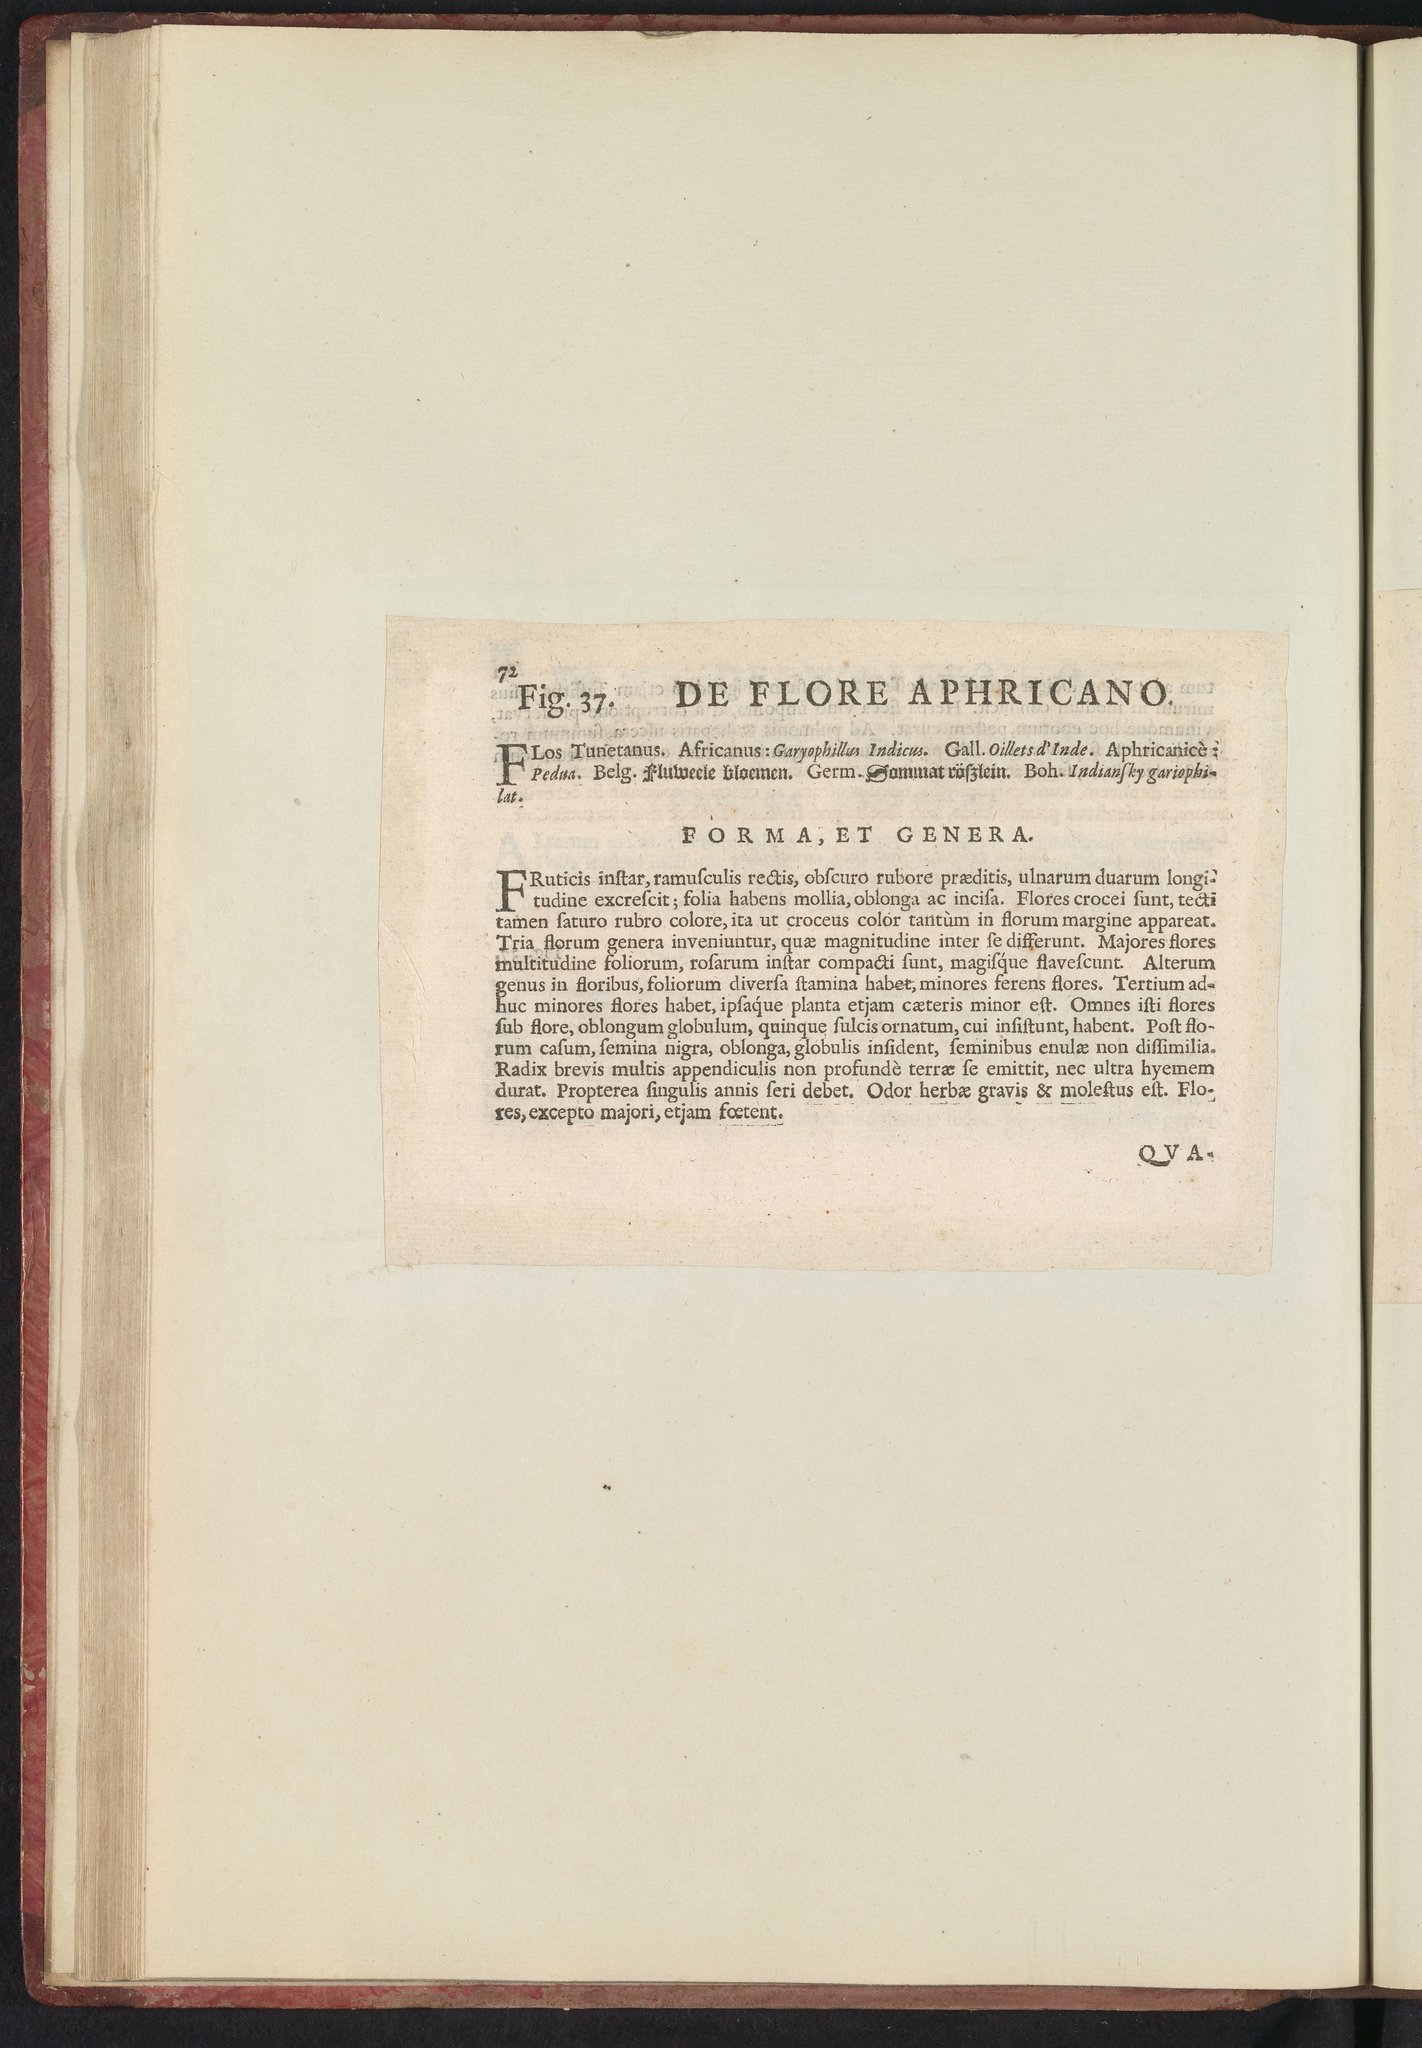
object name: text sheet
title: Fig. 37 'De Flore Aphricano' in De Boodts herbarium van 1640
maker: anselmus boëtius de boodt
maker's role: draughtsman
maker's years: 1550-1632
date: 1640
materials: ink, paper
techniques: letterpress printing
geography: bruges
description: Beschrijving bij Fig. 37 op p. 72 in: Anselmi Boëtii de Boot I.C. Brugensis & Rodolphi II. Imp. Roman. medici a cubiculis Florum, Herbarum, ac fructuum selectiorum icones, & vires pleraeque hactenus ignotæ. Onderdeel van het album met bladen en platen uit De Boodts herbarium van 1640. Het twaalfde van twaalf albums met aquarellen van dieren, vogels en planten bekend rond 1600, gemaakt in opdracht van keizer Rudolf II.